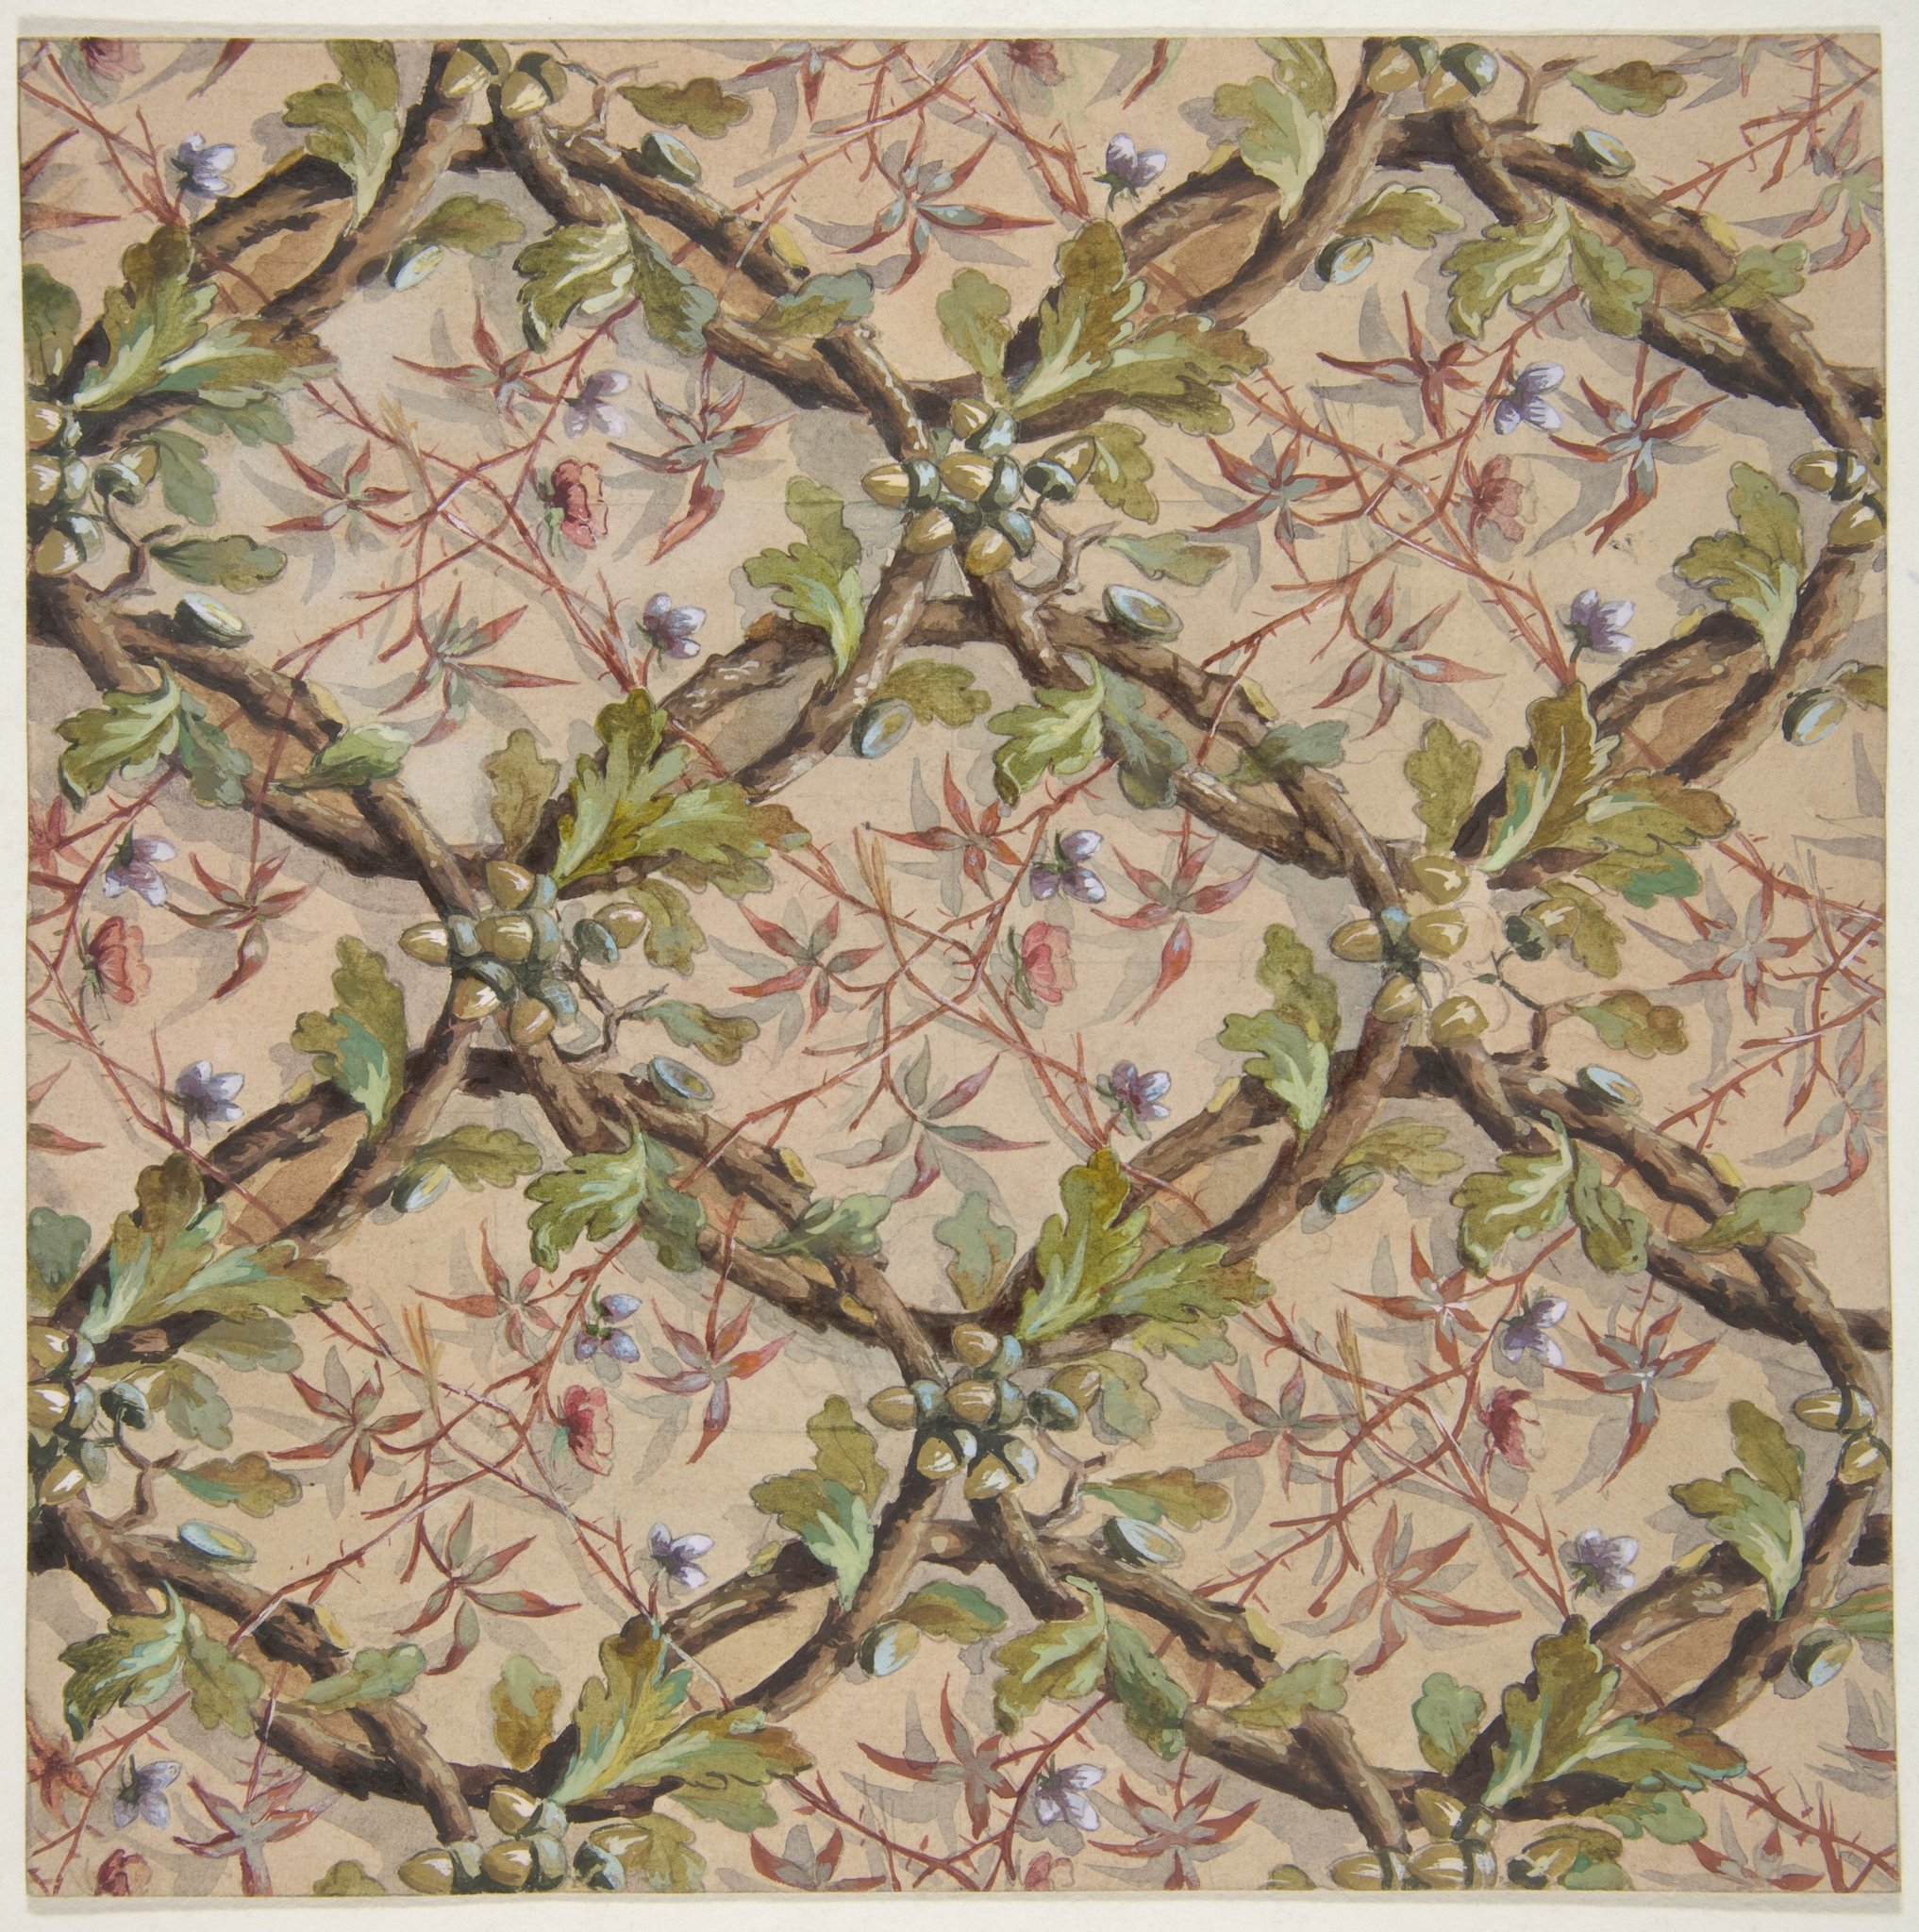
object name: drawing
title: Design for wallpaper featuring oak leaves, acorns, and intertwined twigs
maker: jules-edmond-charles lachaise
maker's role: artist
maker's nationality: french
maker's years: 1897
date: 1830-1897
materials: gouache, paper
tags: flowers,acorns,leaves,oaks